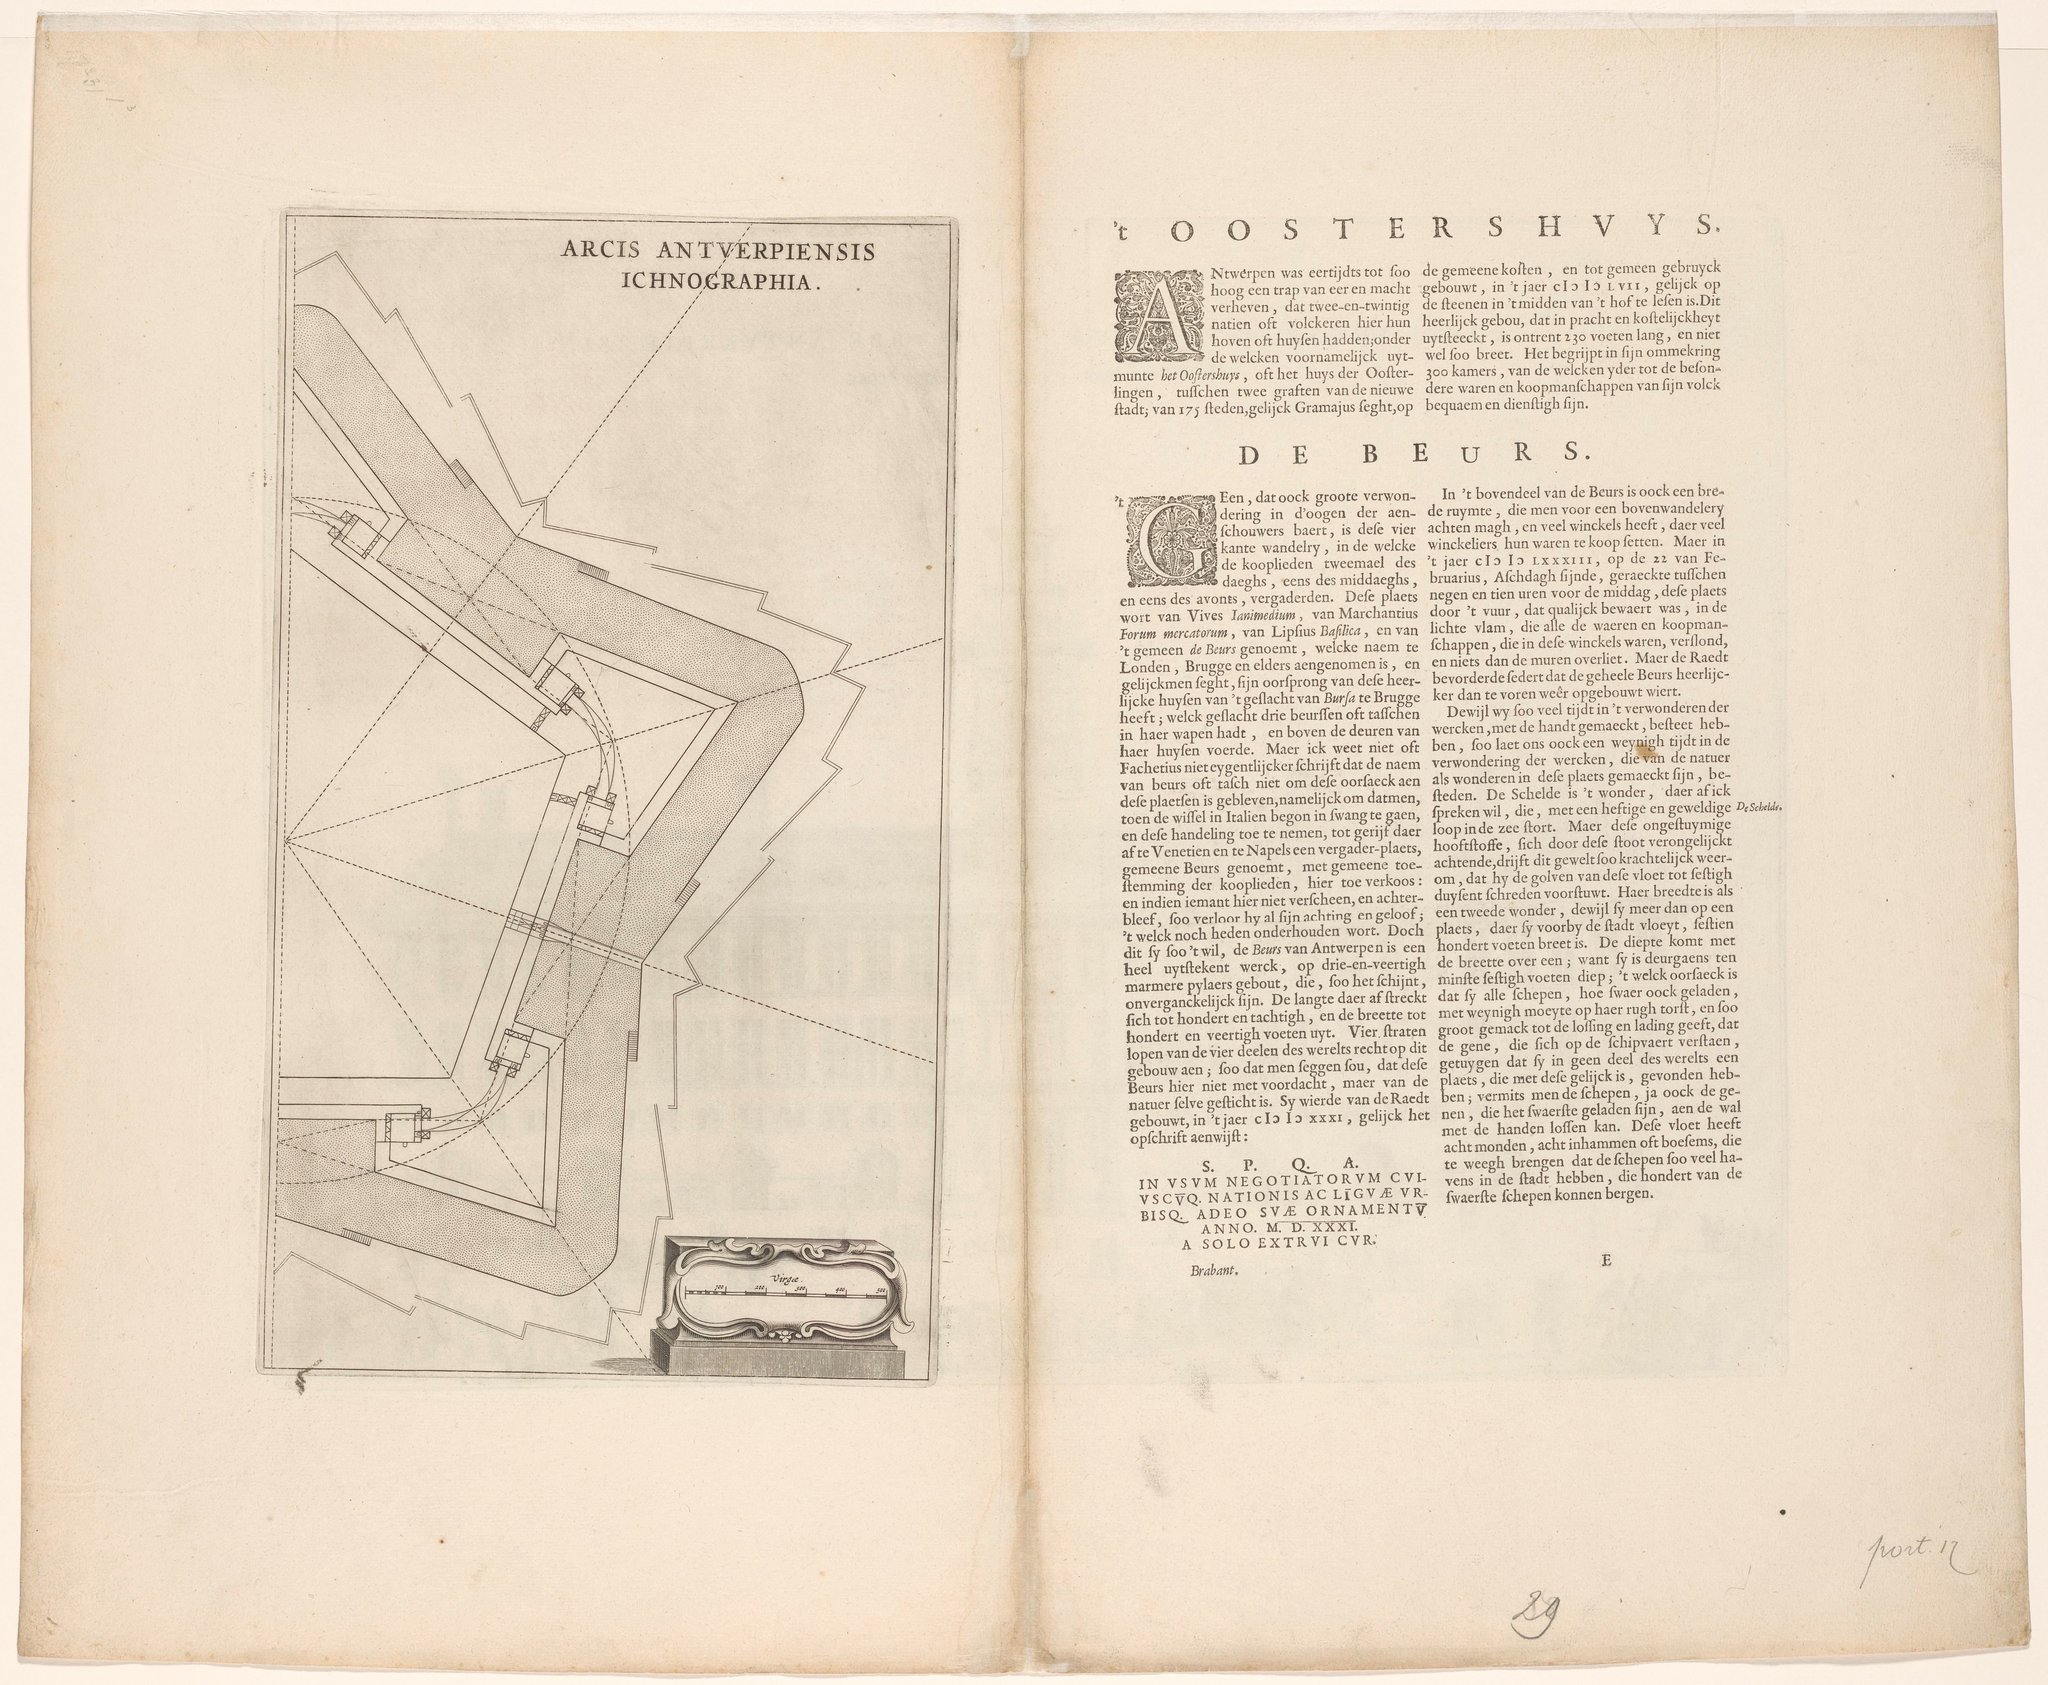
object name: area plan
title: Arcis Antverpiensis ichnographia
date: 1652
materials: paper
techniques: engraving, etching, letterpress printing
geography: amsterdam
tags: maps of cities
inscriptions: collector's mark: Lugt 195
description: Vestingplattegrond van een gedeelte van de Citadel van Antwerpen en tekst over het Oostershuis en de Beurs te Antwerpen. Rechtsonder in de plattegrond een schaalstok: 500 Virgae. Op recto een prent.